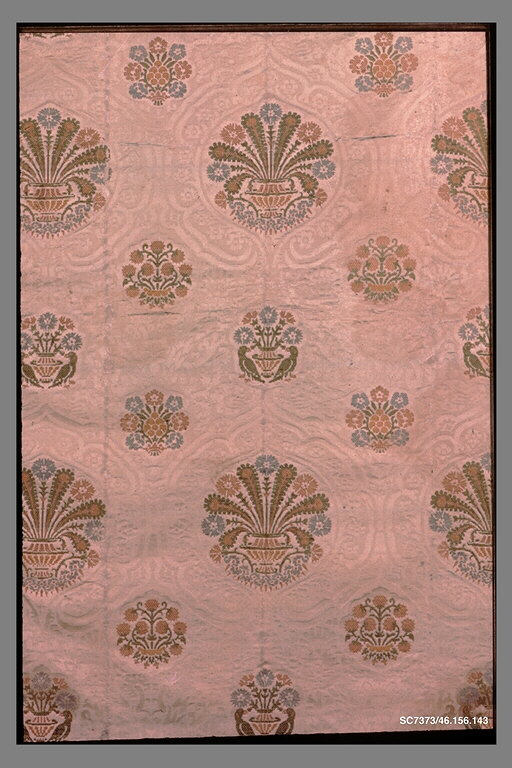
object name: panel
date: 1451-1500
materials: silk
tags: flowers